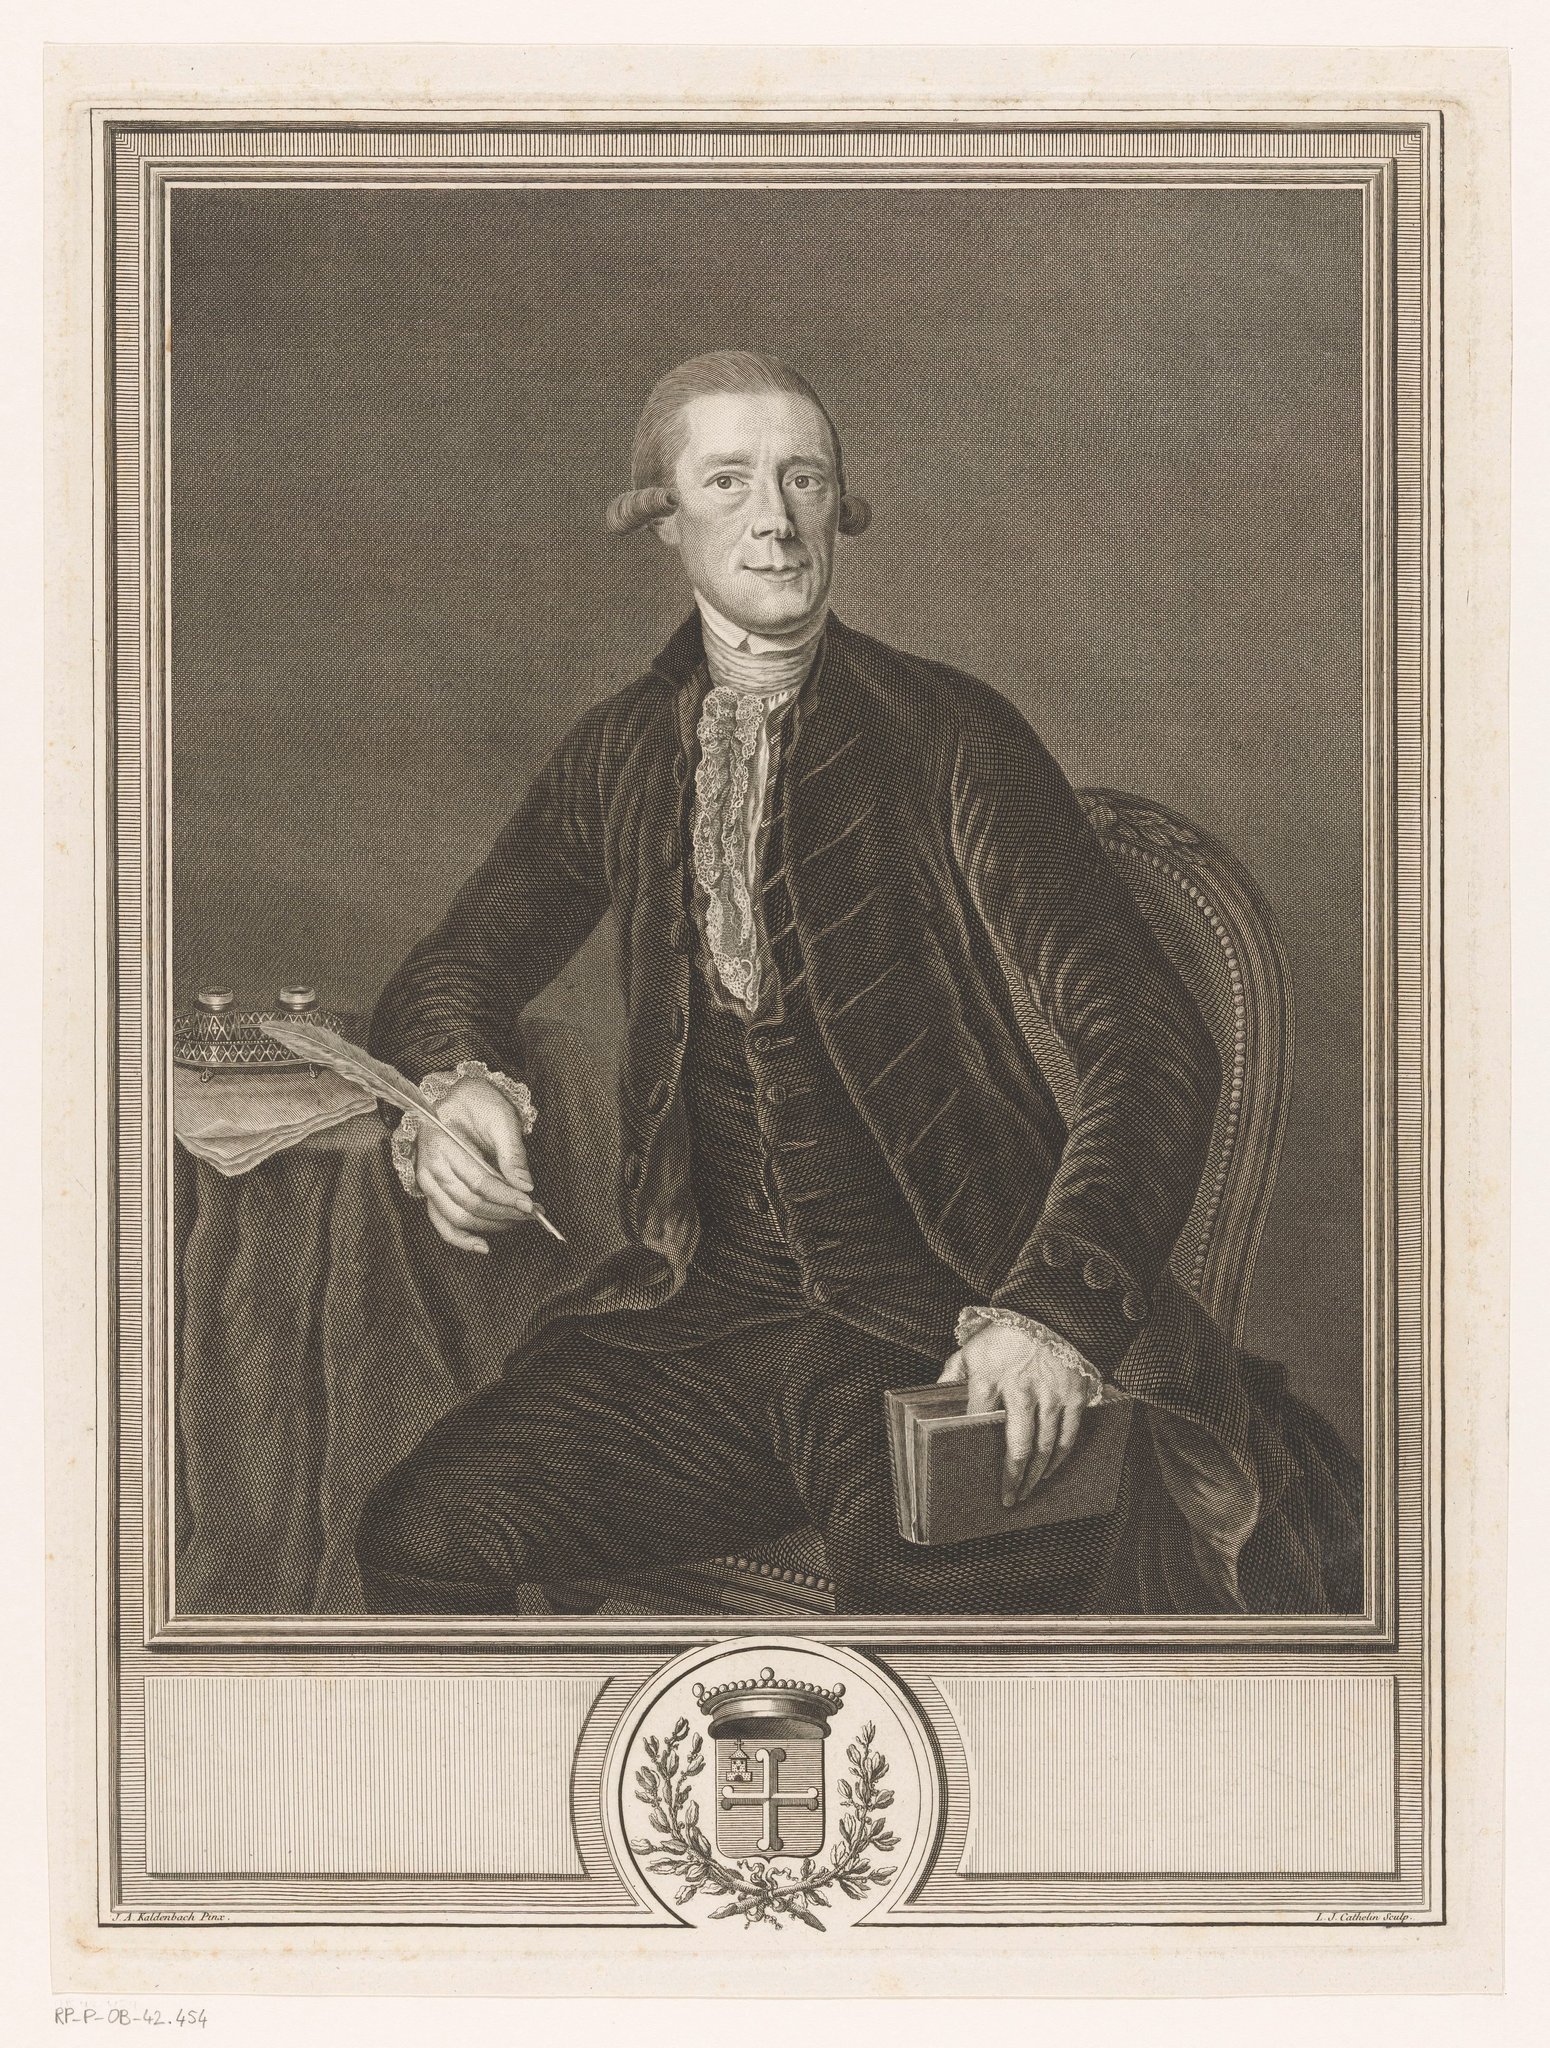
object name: print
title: Portret van Joan Derk van der Capellen tot den Pol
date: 1770-1804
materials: paper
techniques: engraving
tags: politician, joan derk van der capellen tot den pol, quill, historical persons, politician, e.g. party leader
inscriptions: collector's mark: Lugt 2228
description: Bijgevoegd zijn twee opzetvellen met in totaal vijf gedichten op het geschilderde portret van Joan Derk van der Capellen door P. 't Hoen, Jan de Kruyff, D. van Alphen, P. van Schelle en A. Blussé. Joan Derk van der Capellen tot den Pol, heer van Appeltern enz., Nederlands politicus en patriot, schrijver van het anoniem verschenen pamflet 'Aan het Volk van Nederland' (in de nacht van 25 op 26 september 1781 in verschillende steden in Nederland verspreid).